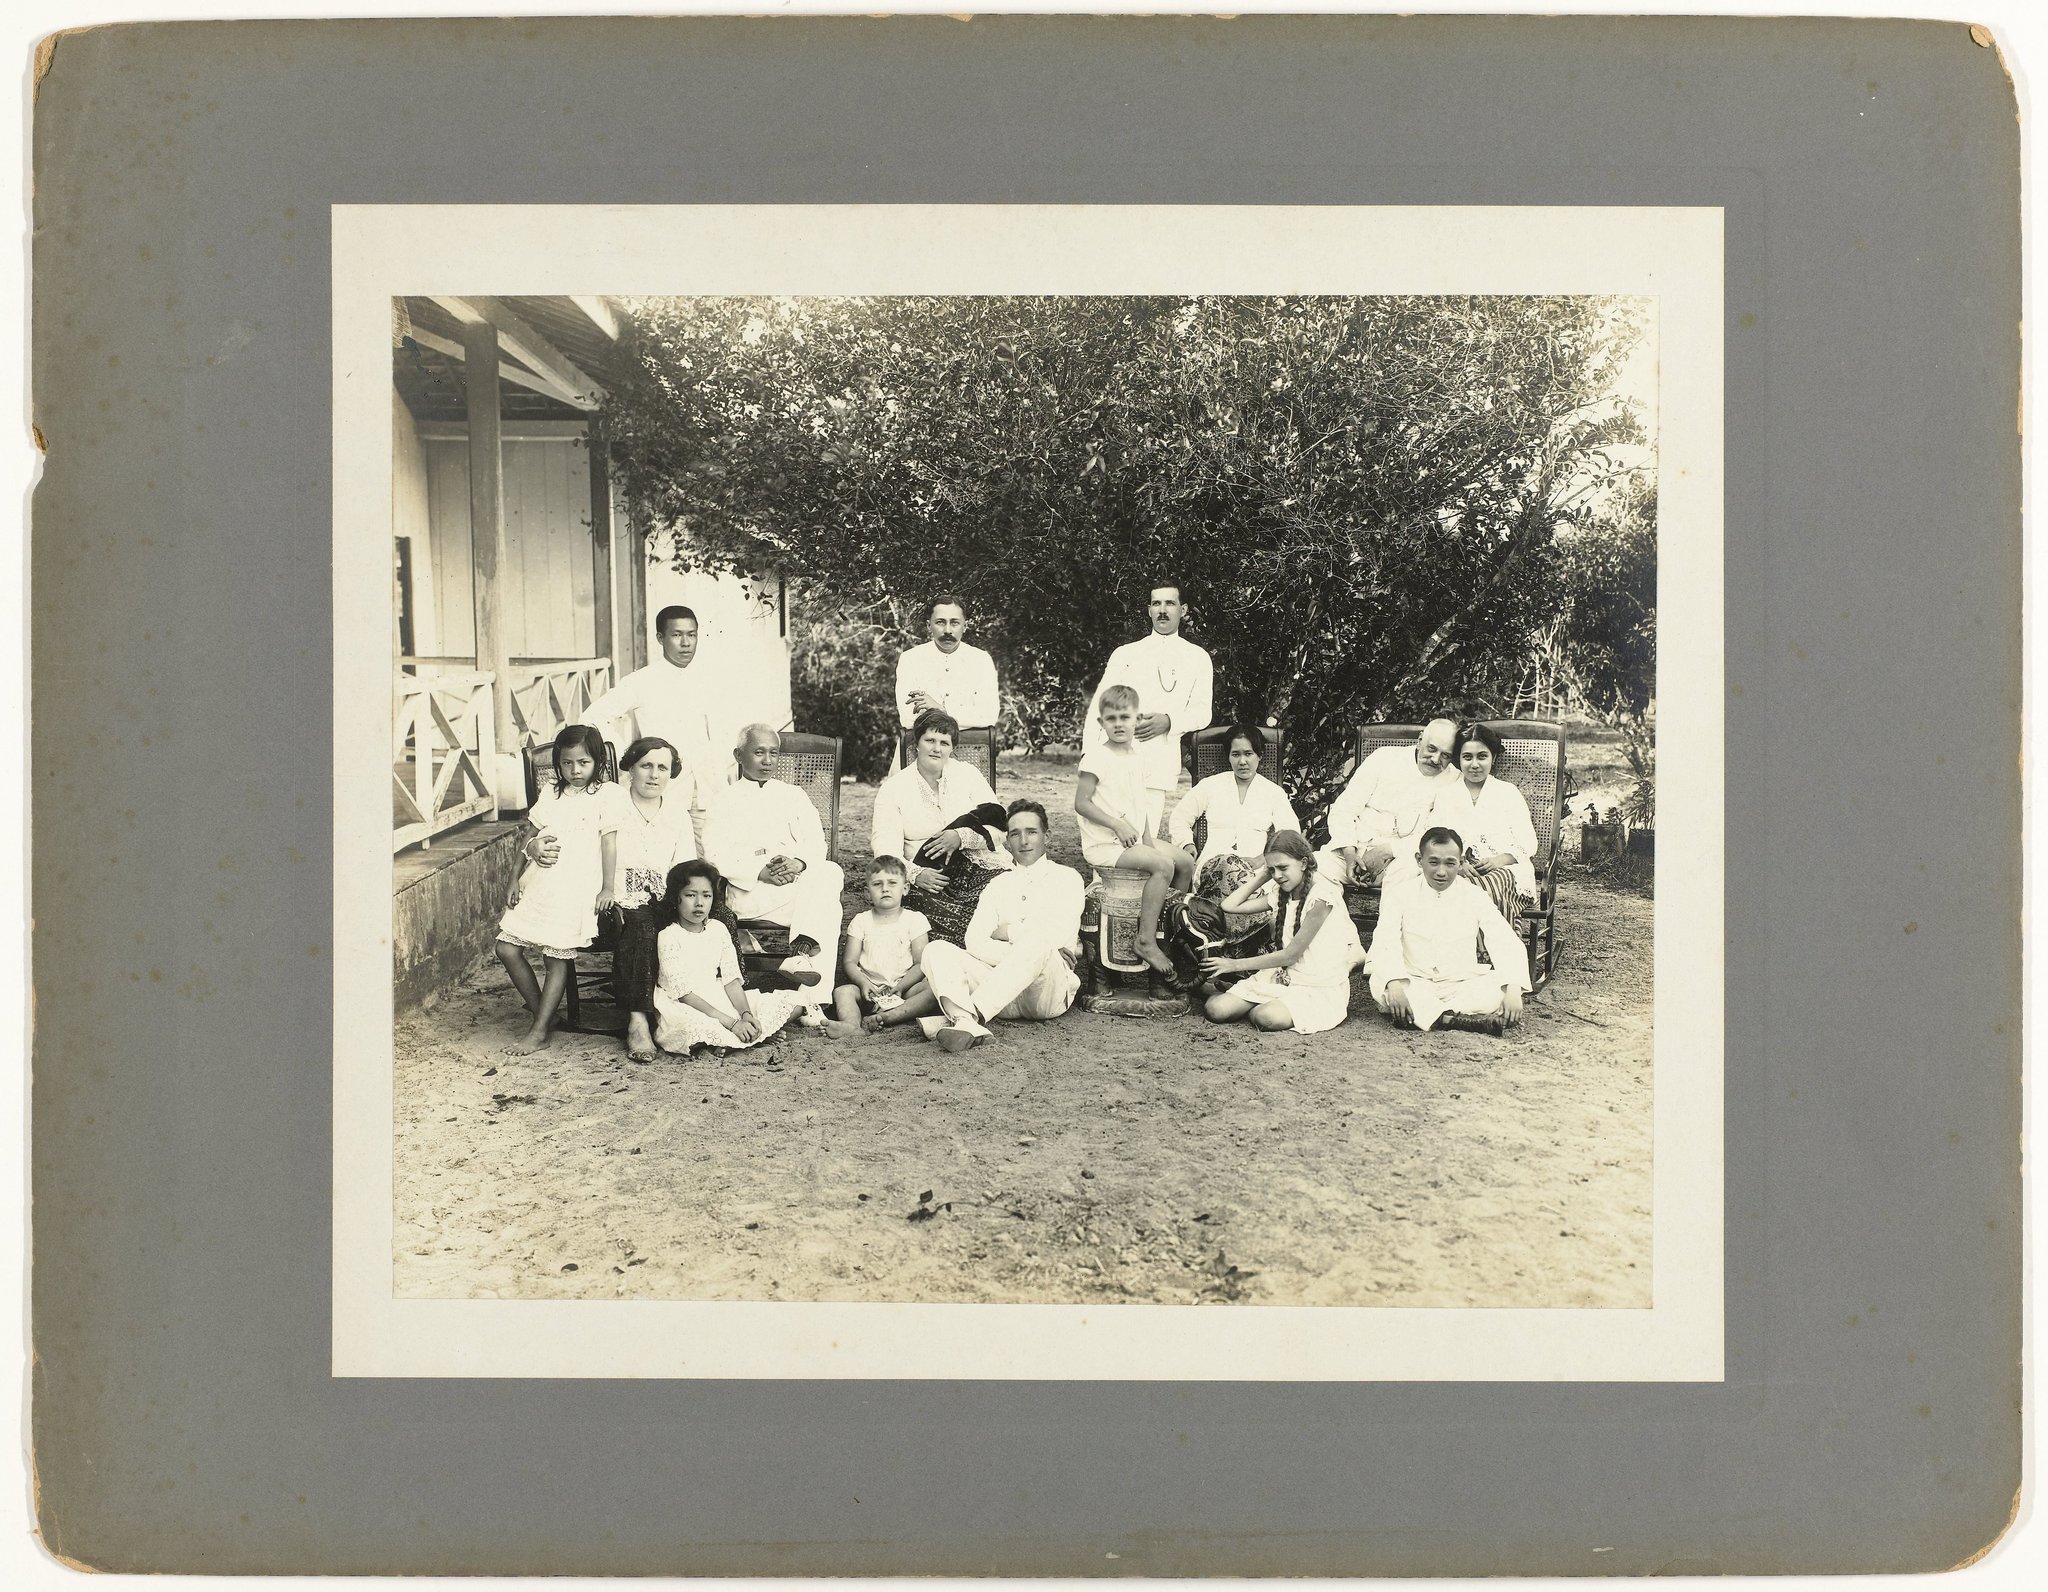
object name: photograph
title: Portret van familie Boers met personeel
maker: Anonymous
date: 1919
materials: cardboard, photographic support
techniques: photography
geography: bangka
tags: robert julius boers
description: Groepsfoto van de familie van Robert Julius Boers, chef van de Banka-tinwinning, met personeel, totaal 16 personen. Links een deel van de veranda van de houten woning; op achtergrond struiken. Geplakt op donkergrijs karton.